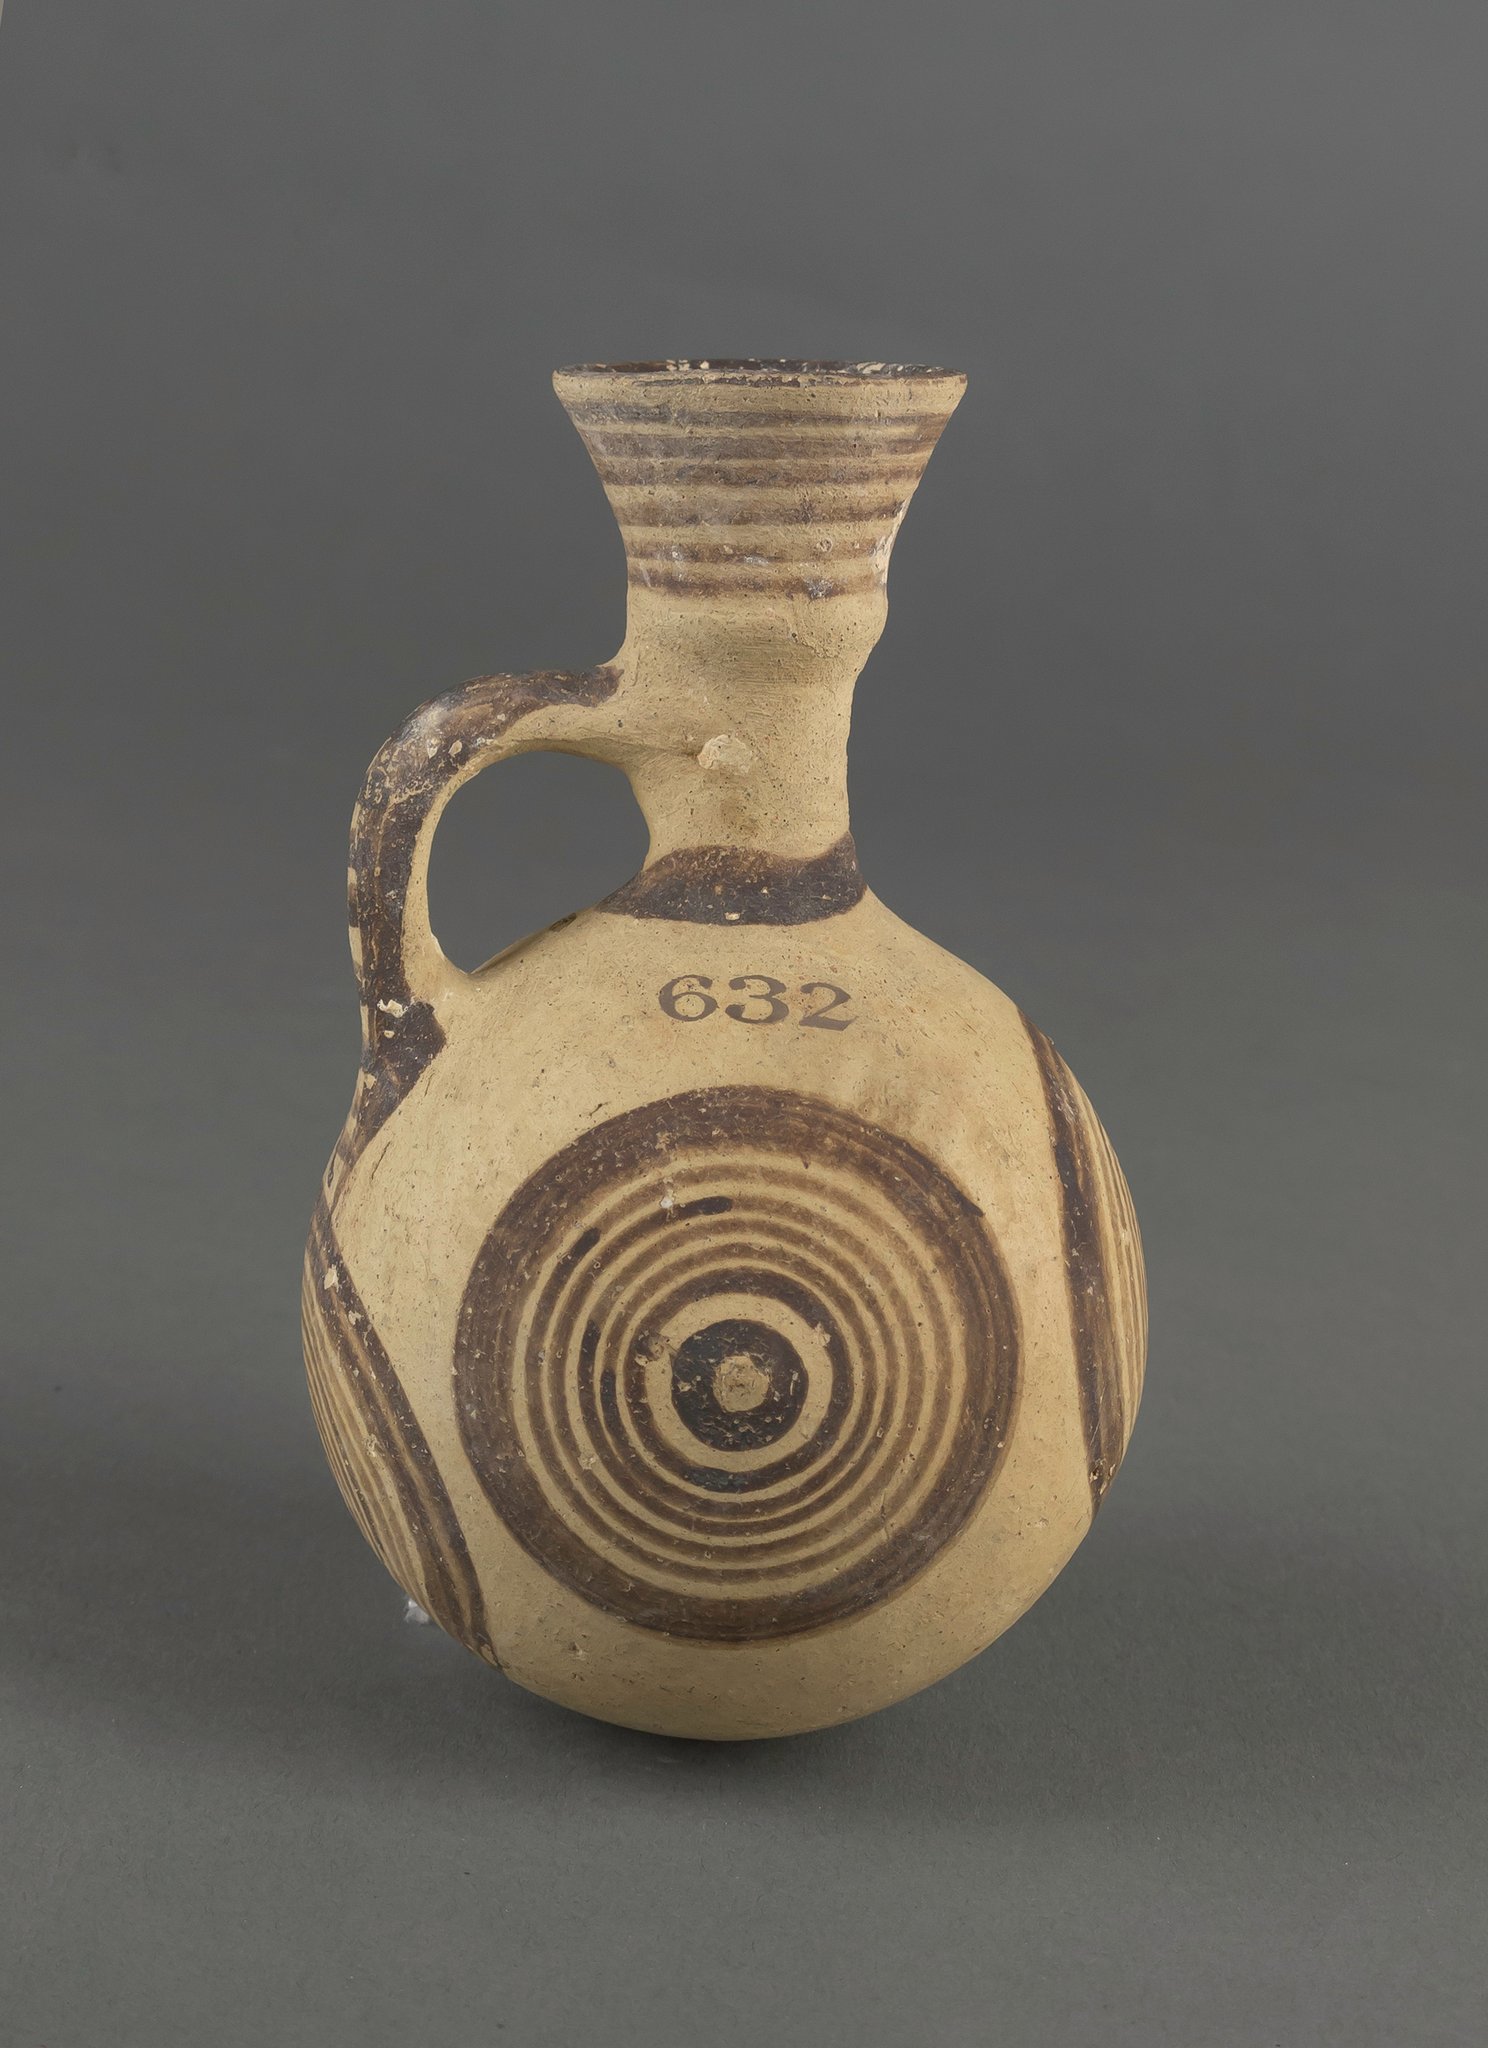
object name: juglet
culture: cypriot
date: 850-750 BCE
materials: terracotta